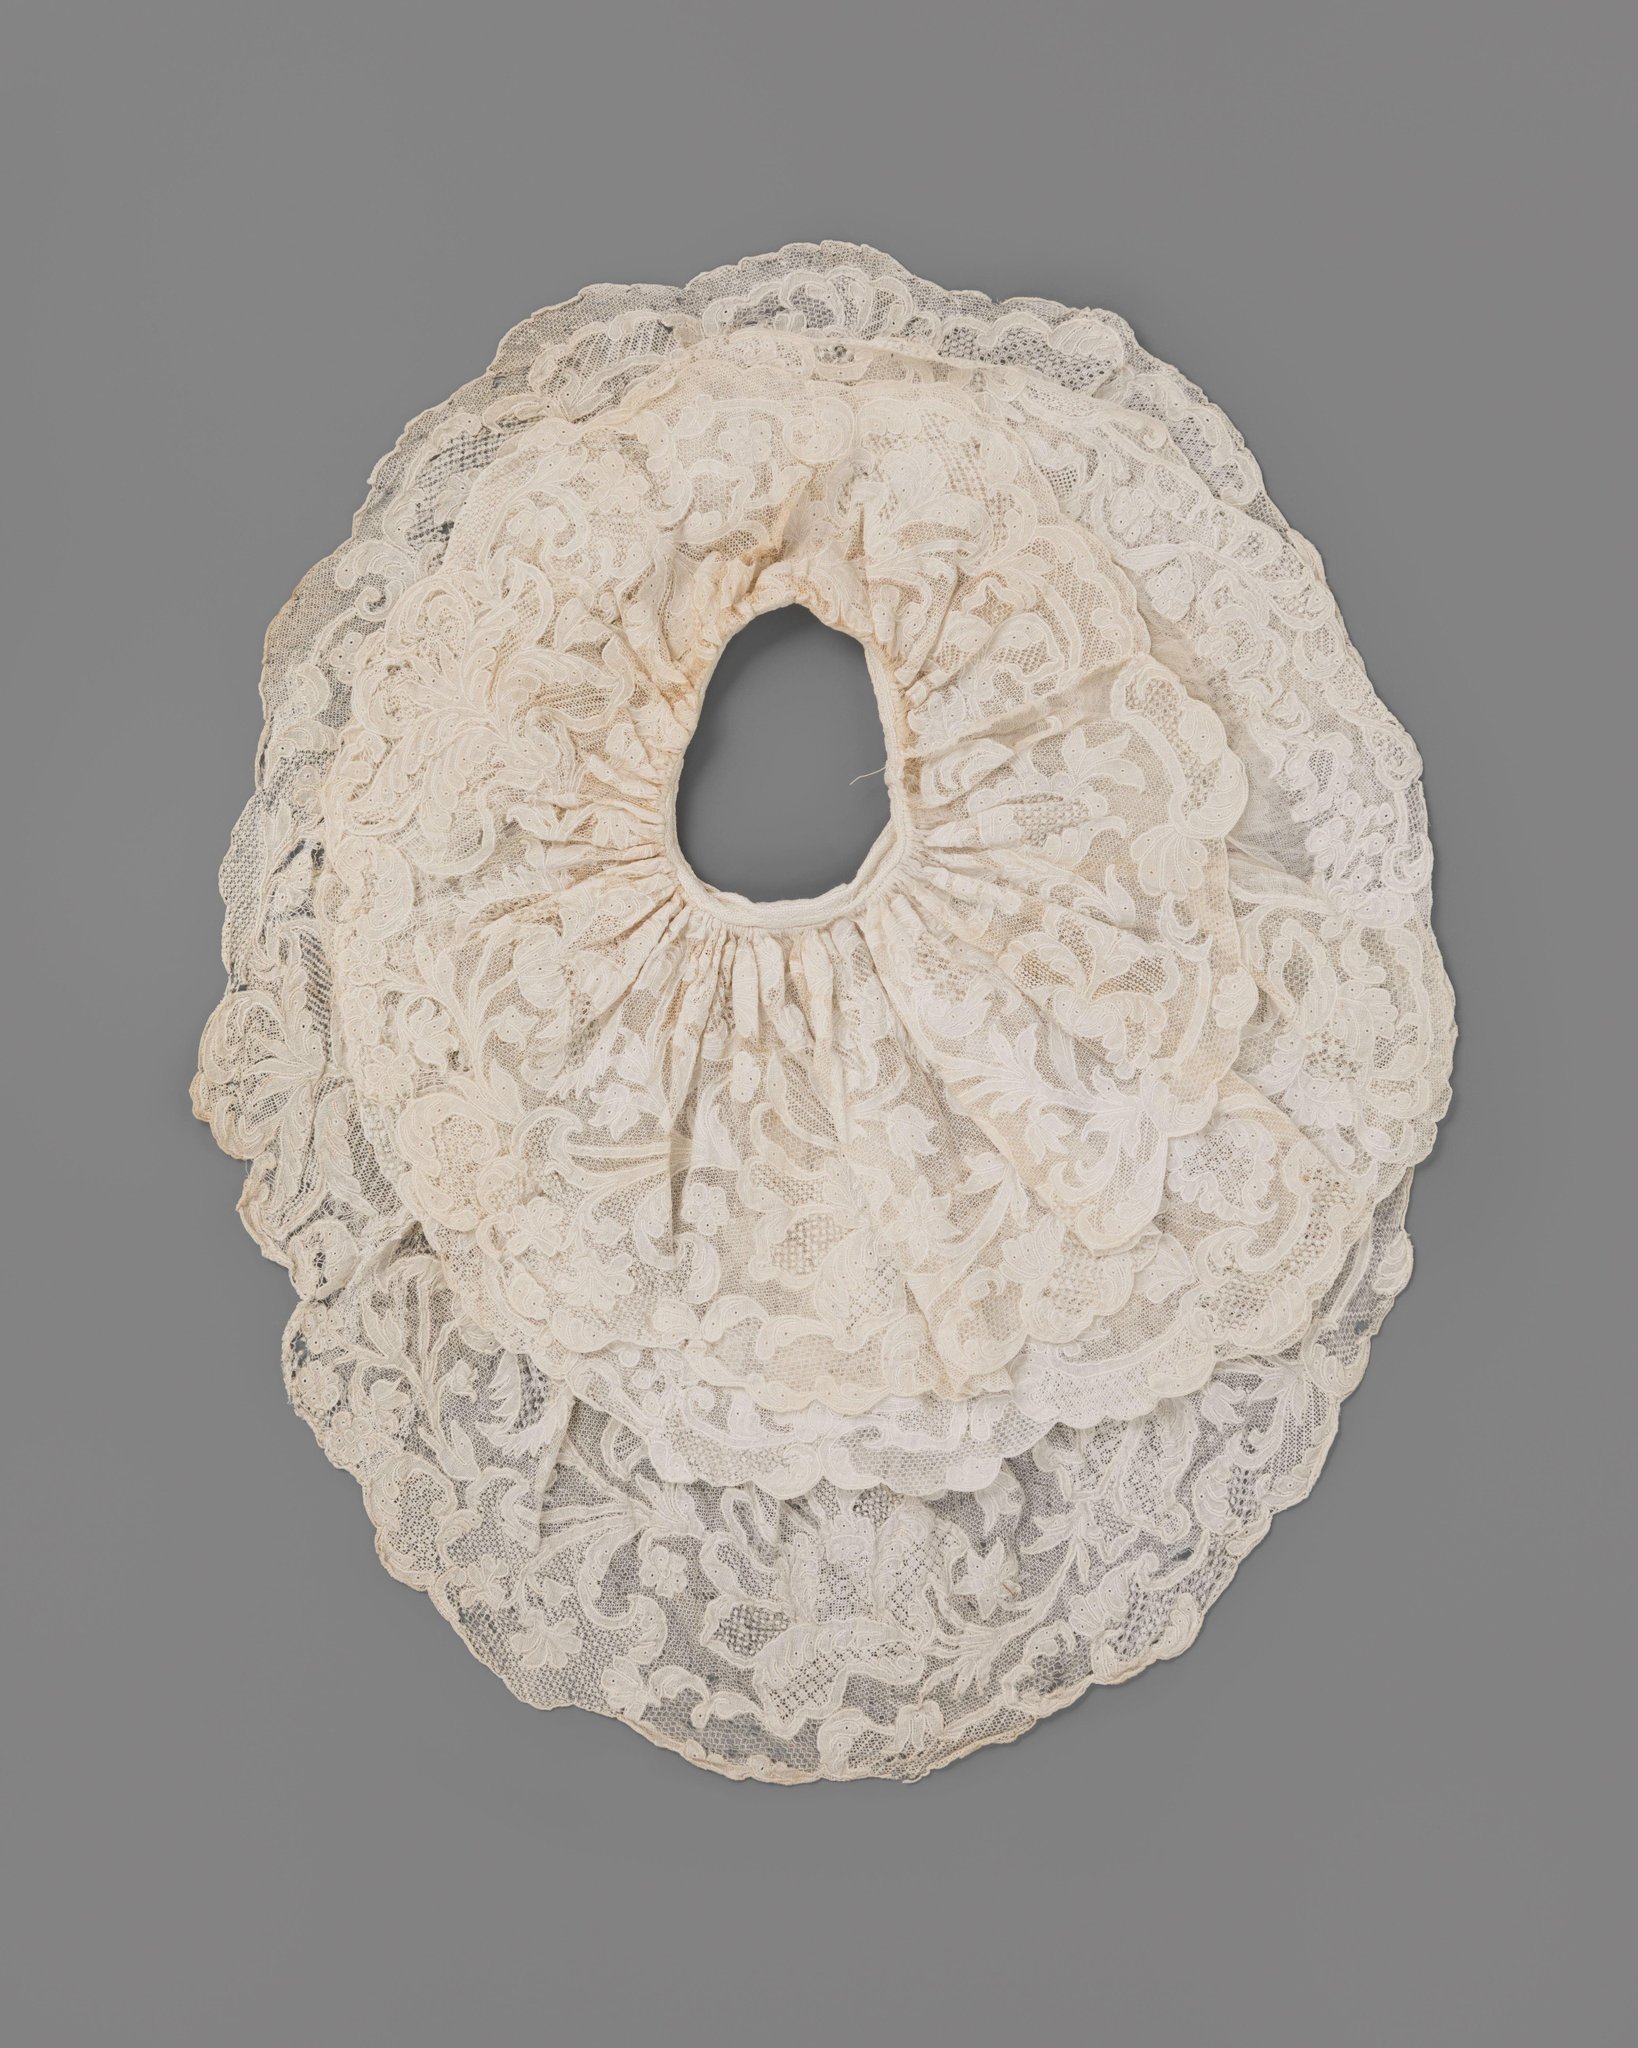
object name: womenswear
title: Engageante met een doorlopend patroon van gecordonneerd applicatiewerk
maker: Anonymous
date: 1750-1900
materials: lace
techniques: embroidered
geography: western europe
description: Engageante bestaande uit drie stroken versierd met een doorlopend patroon van ranken, bladeren en bloemen in gecordonneerd applicatiewerk. De fonds en de vullingen zijn van Vlaams open naaiwerk in afwisselende motieven.